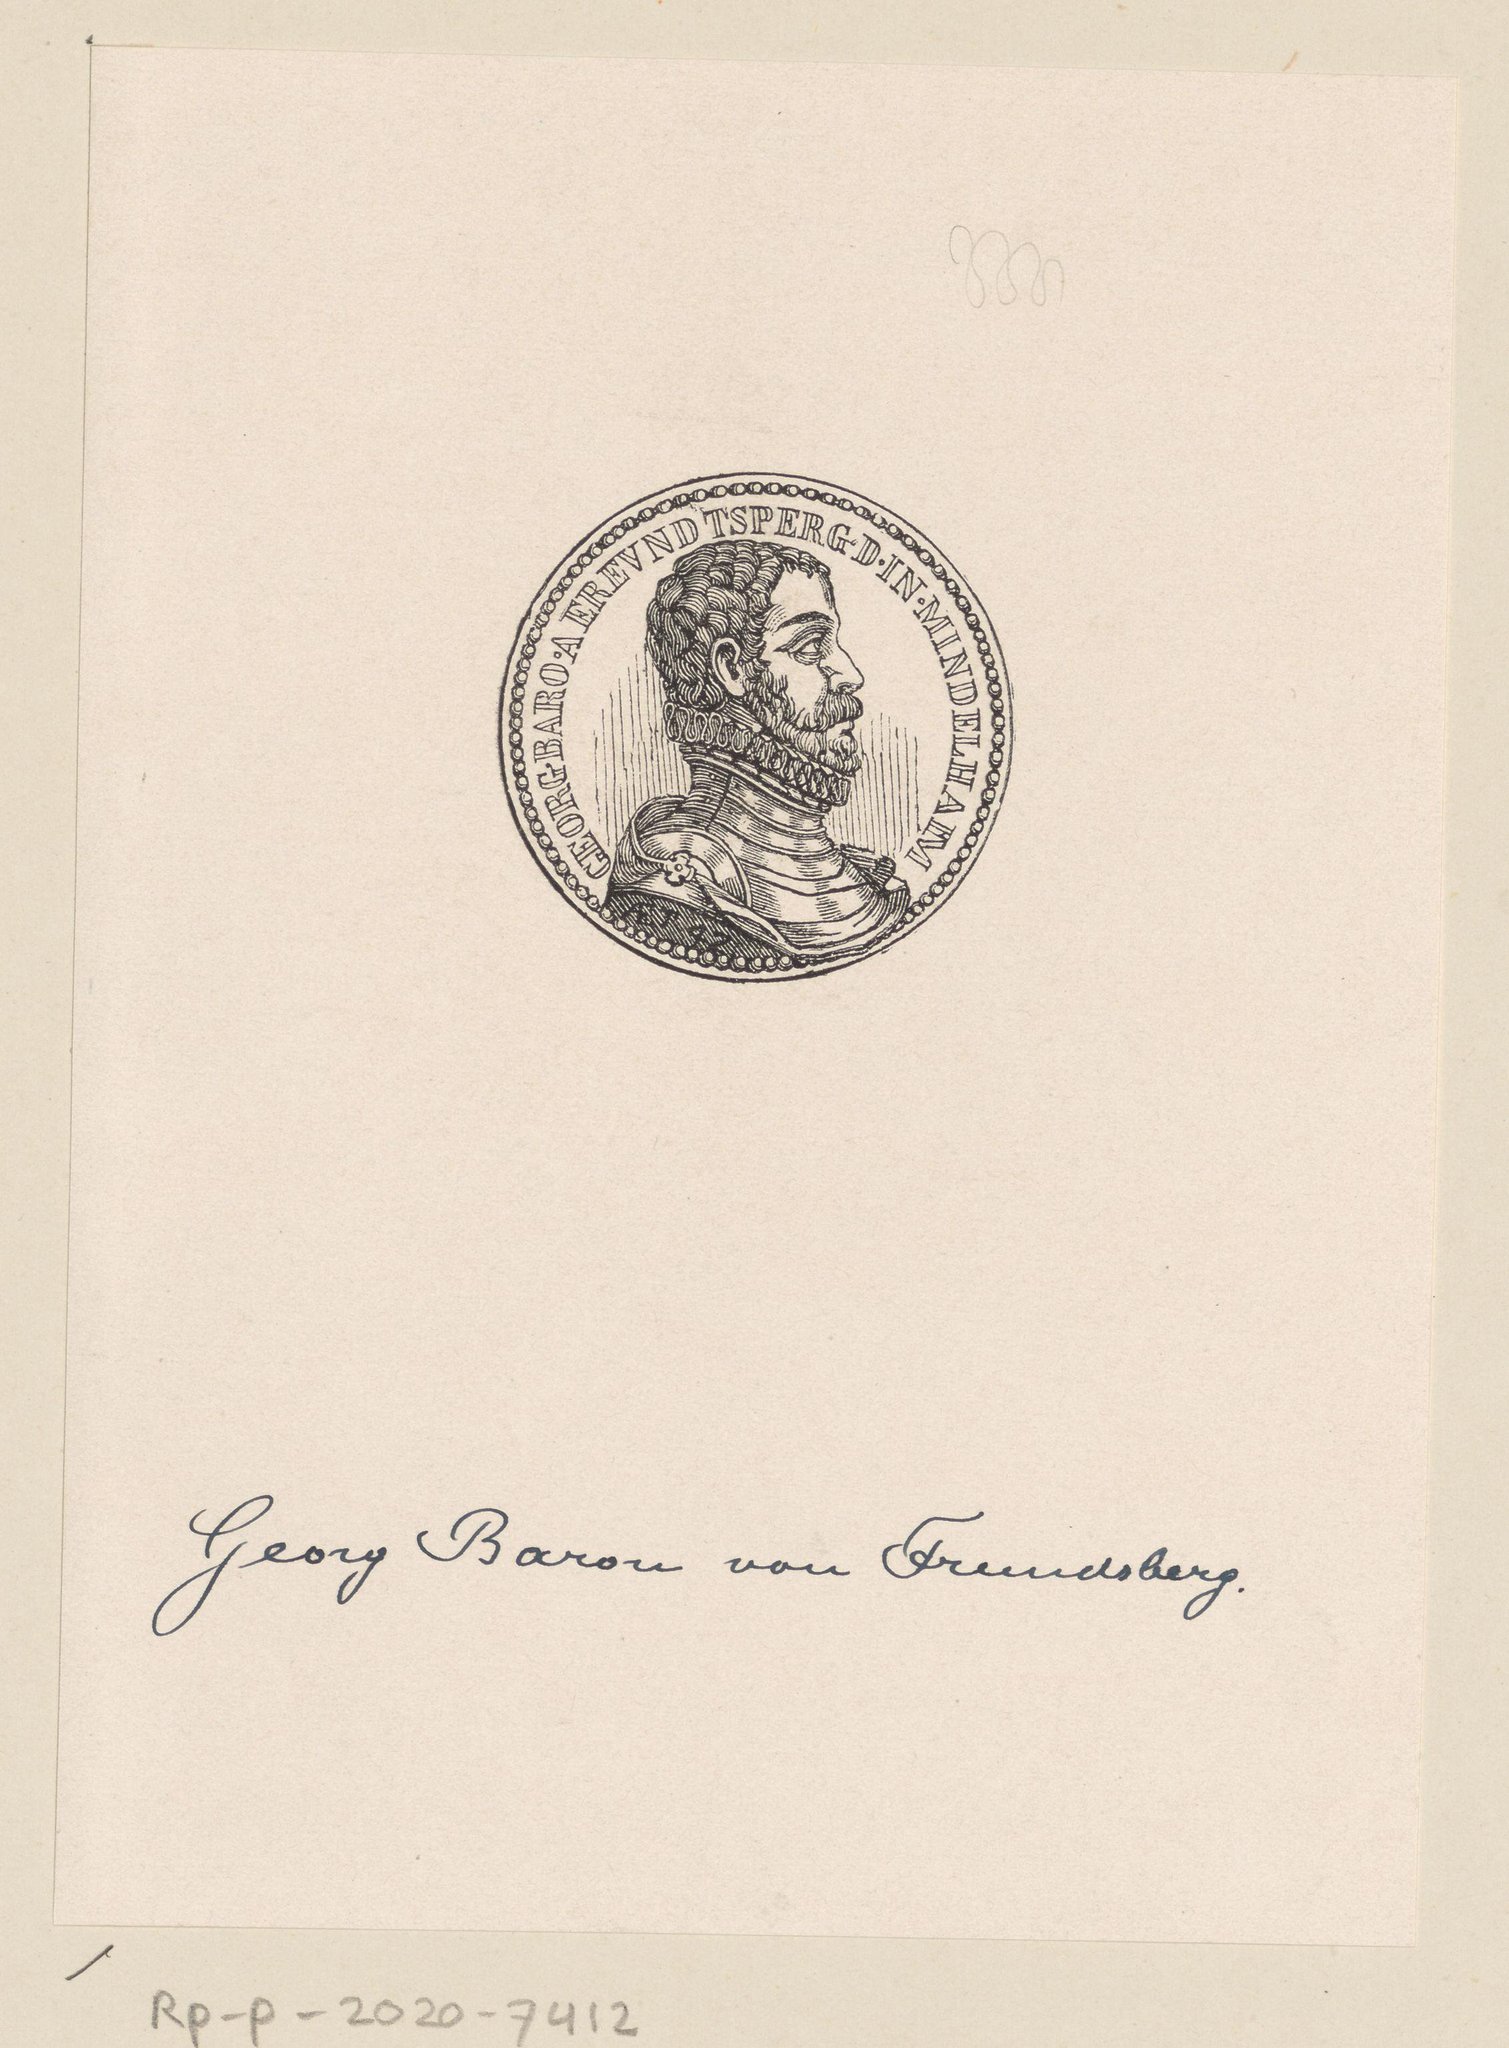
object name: print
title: Penning met het portret van Georg von Frundsberg op 42-jarige leeftijd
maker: Anonymous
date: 1800-1899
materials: paper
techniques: engraving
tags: historical persons, coin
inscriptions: inscription: ‘Georg Baron von Freundsberg’